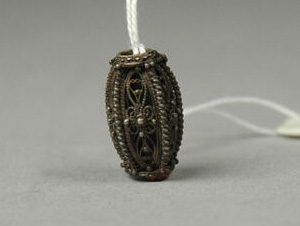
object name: ojime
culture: japanese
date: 1801-1900